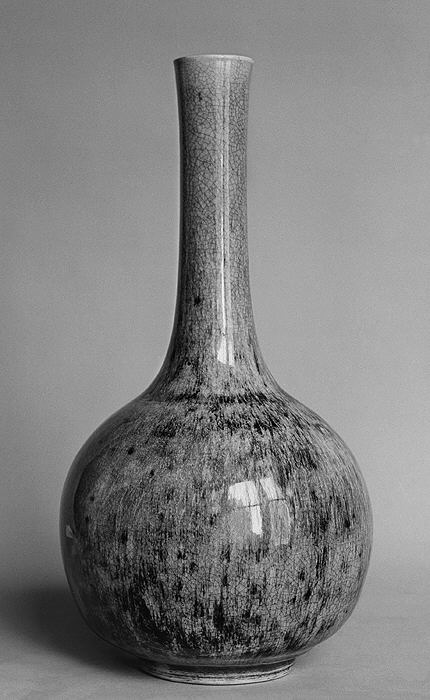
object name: bottle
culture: chinese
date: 1662-1722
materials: porcelain